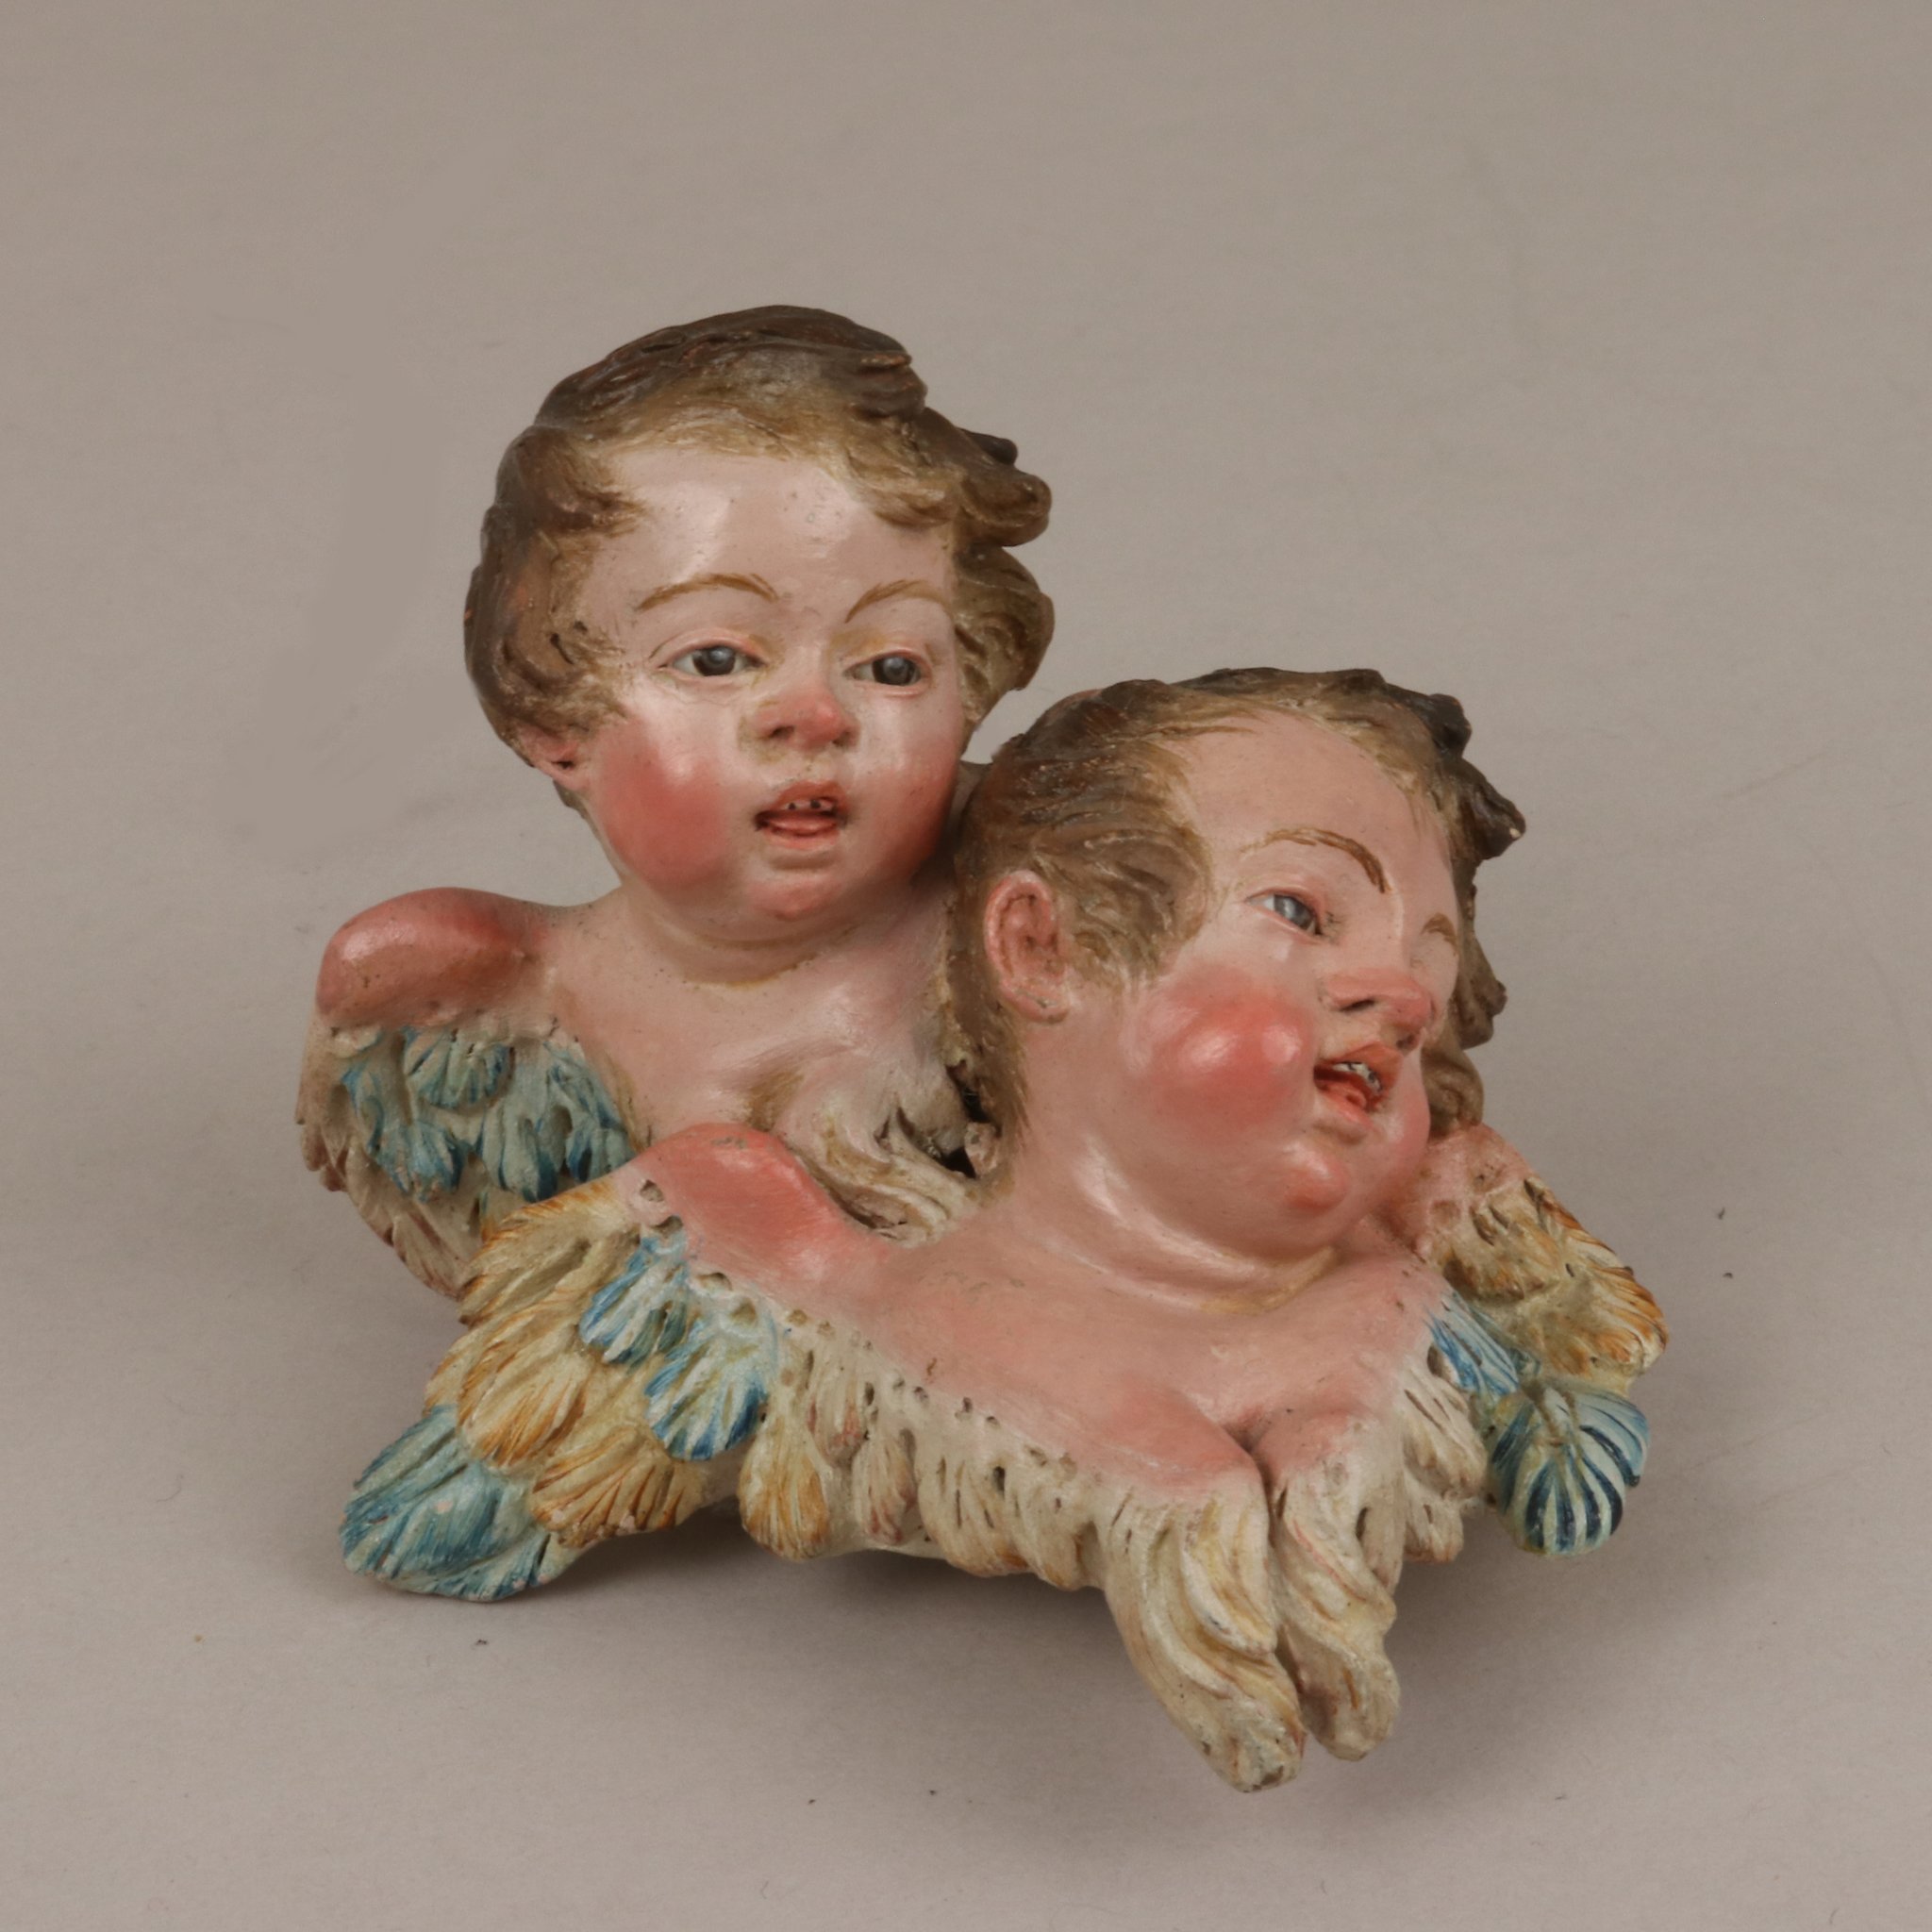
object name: crèche figure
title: Double putti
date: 1701-1800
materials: terracotta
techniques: polychrome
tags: putti